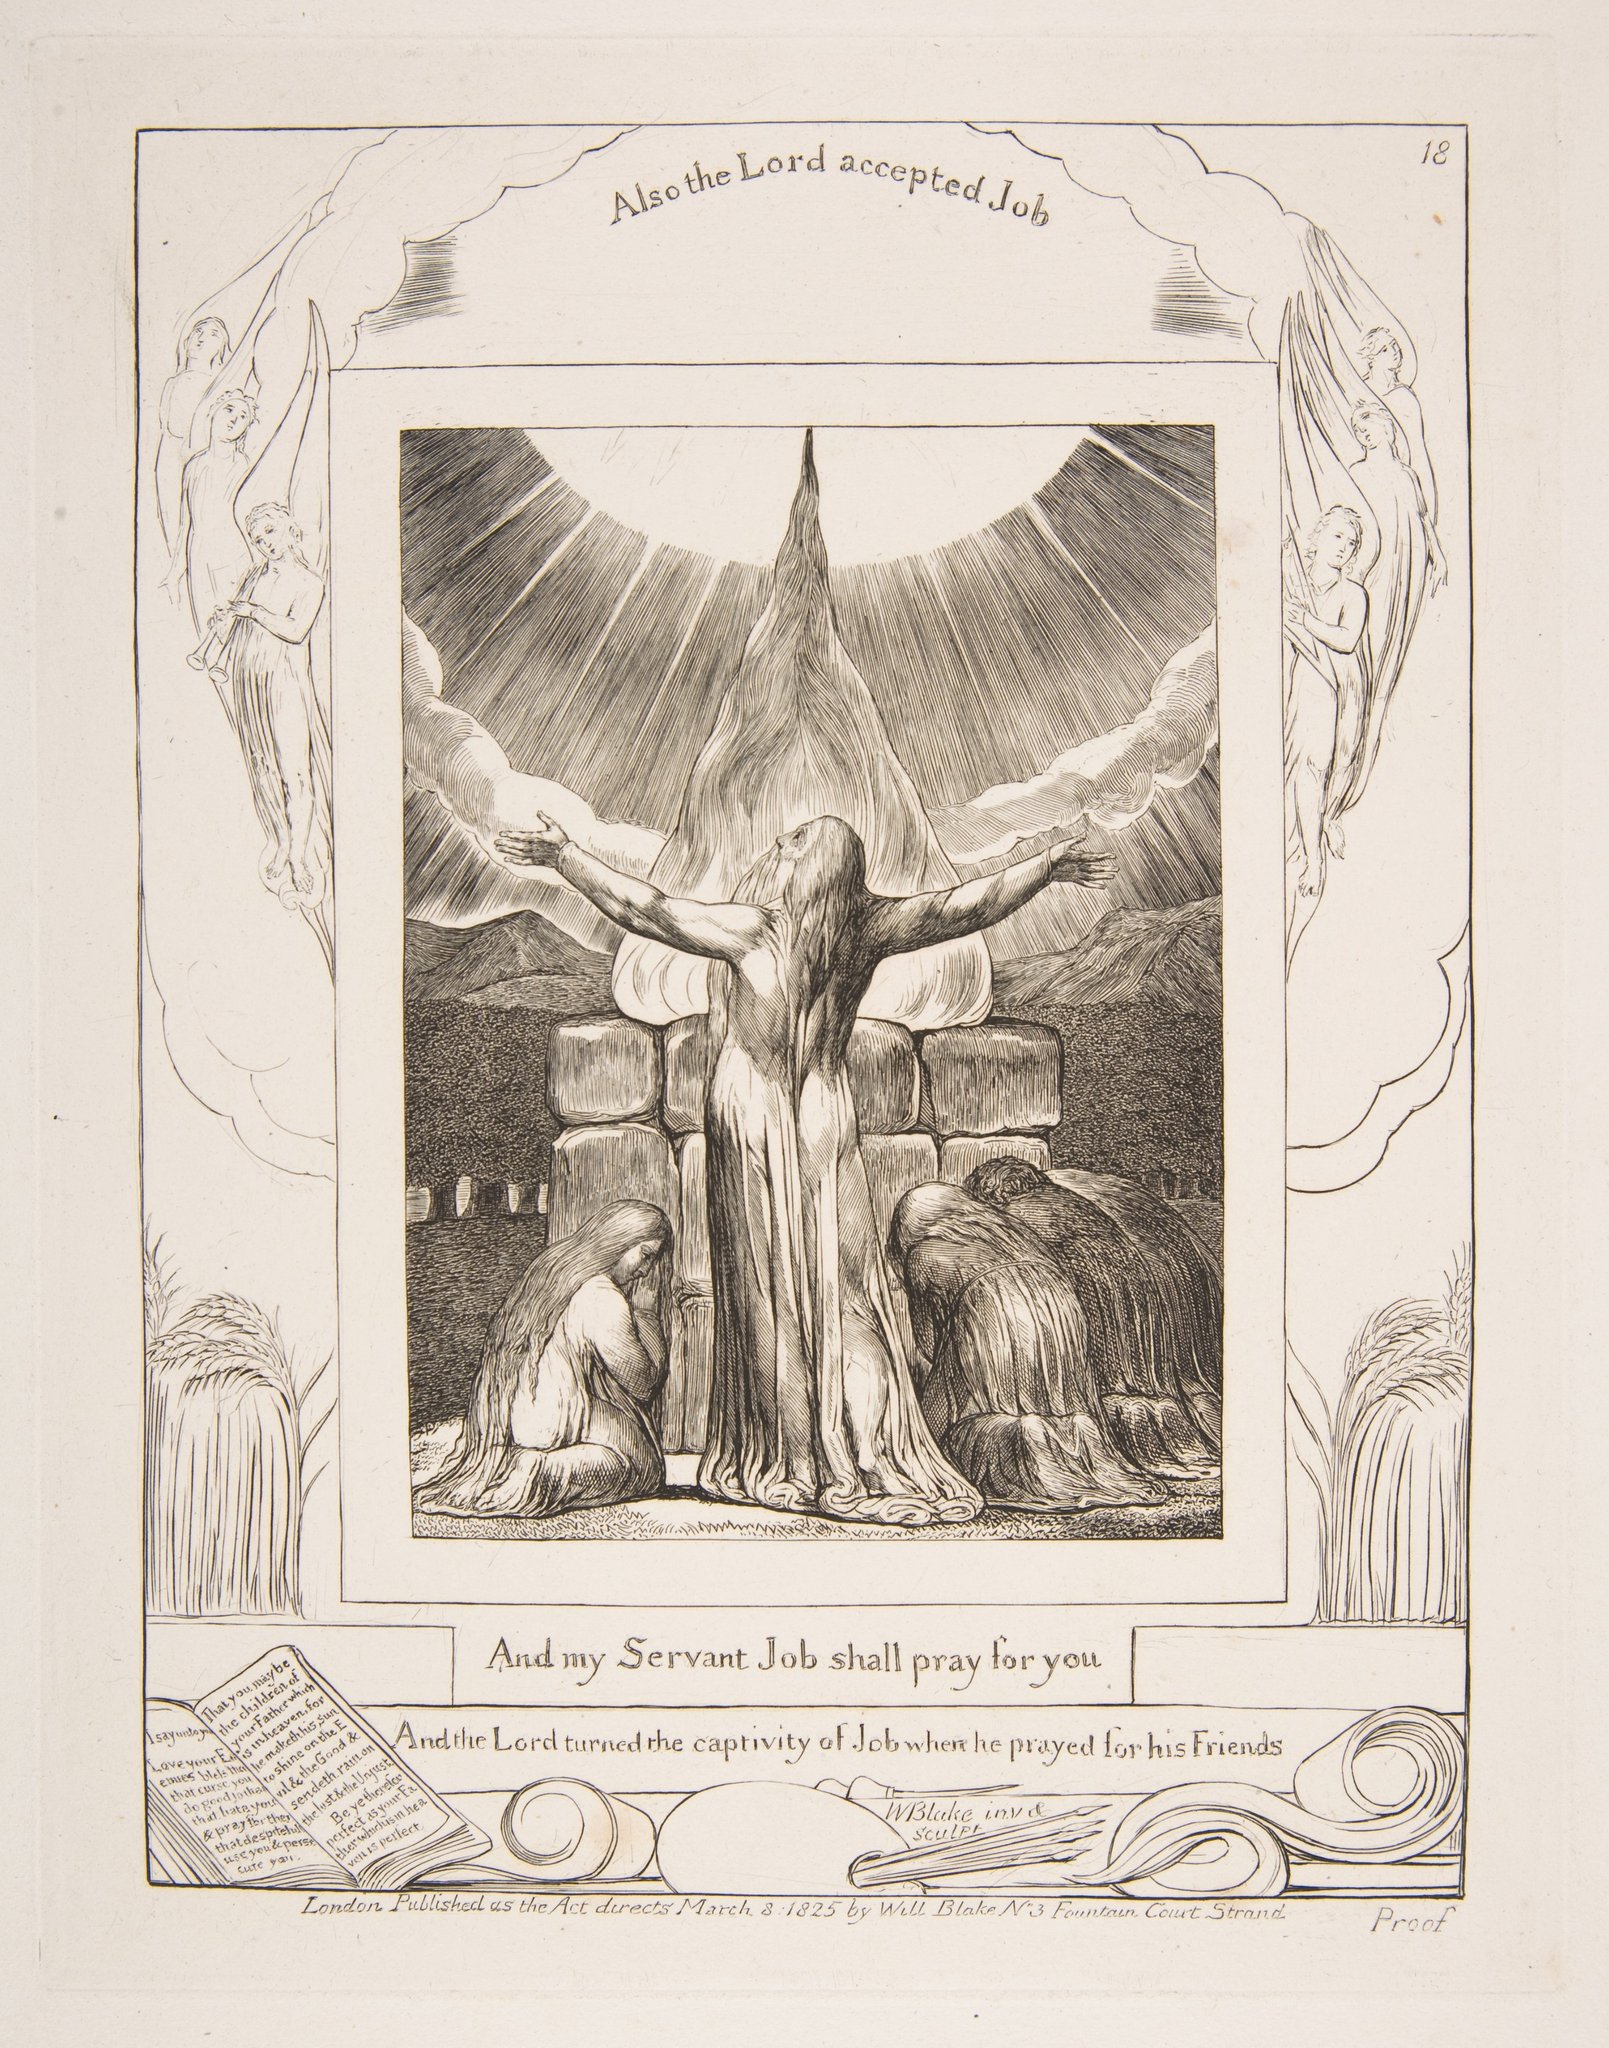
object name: print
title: Job's Sacrifice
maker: william blake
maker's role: artist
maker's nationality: british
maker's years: 1757-1827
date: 1825-1826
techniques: engraving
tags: women,angels,job